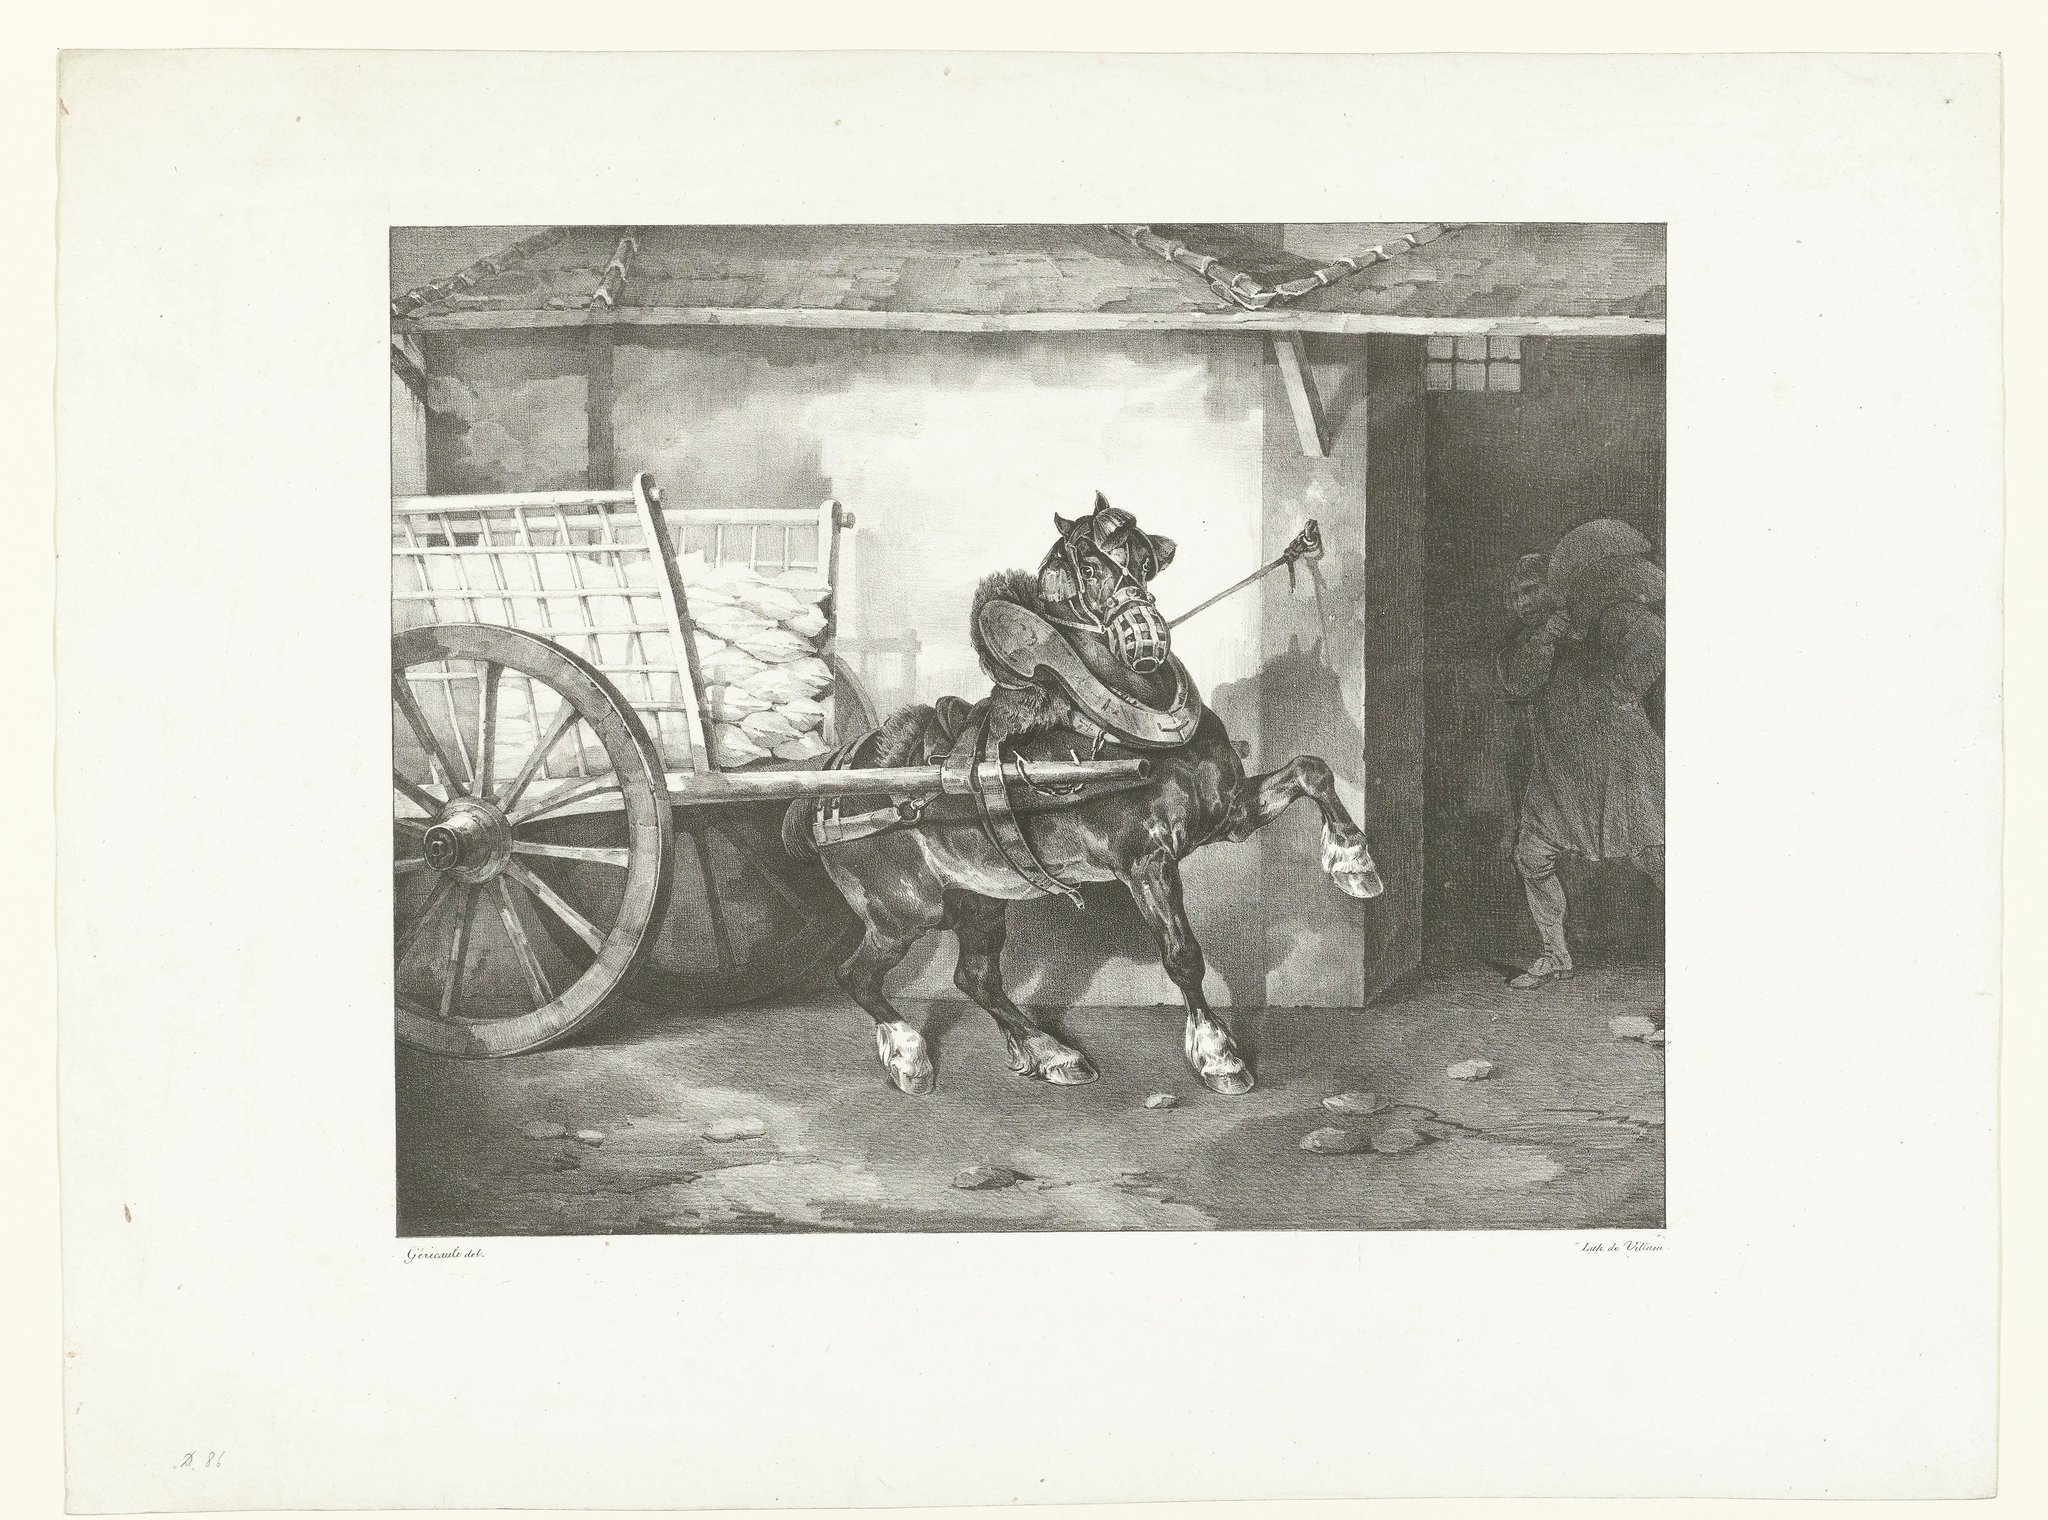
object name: print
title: Etudes de chevaux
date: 1822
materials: paper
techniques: lithograph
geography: paris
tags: stuccoeing, horse (+ conveyance for transport of loads and cargoes)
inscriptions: collector's mark: Lugt 2228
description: Een onrustig paard, met een muilkorf om, ingepannen voor een kar. De stukadoor komt aanlopen, twee zakken op zijn schouder dragend. Uit een serie van twaalf prenten.